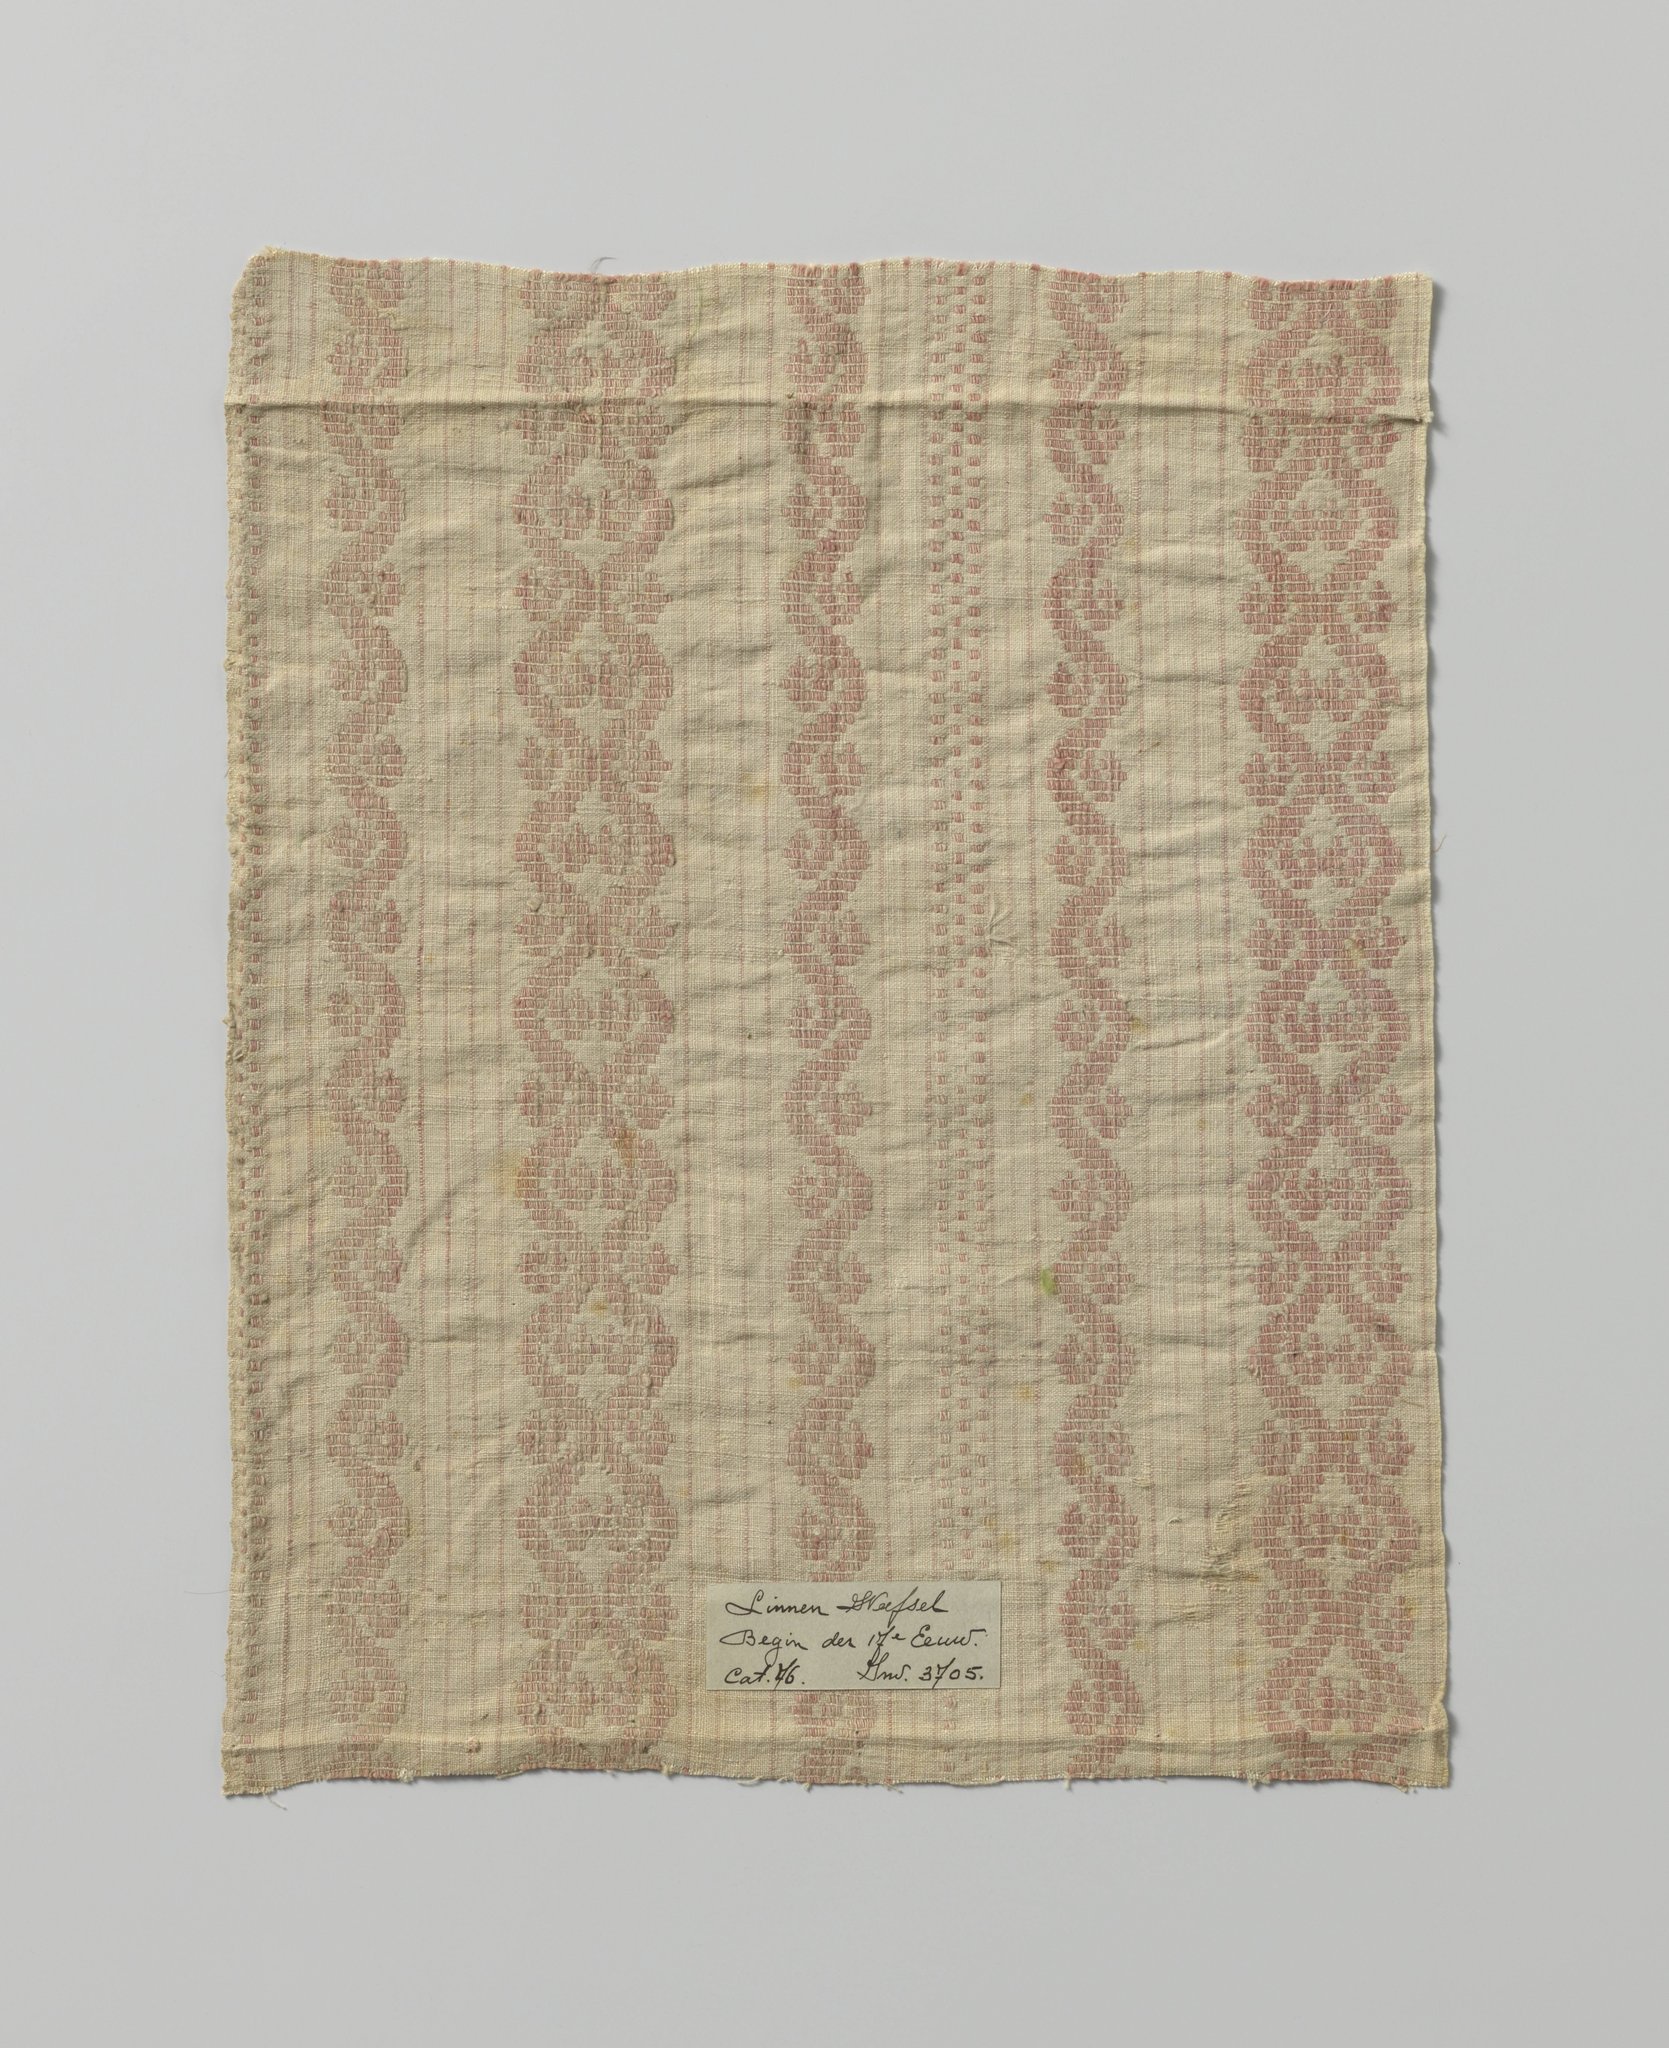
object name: silk textile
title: Fragment met op wit fond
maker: Anonymous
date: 1680-1690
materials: linen, wool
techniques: gadrooning, weave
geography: netherlands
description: Fragment met op wit fond verticale lichtrode strepen en slingerende banden.